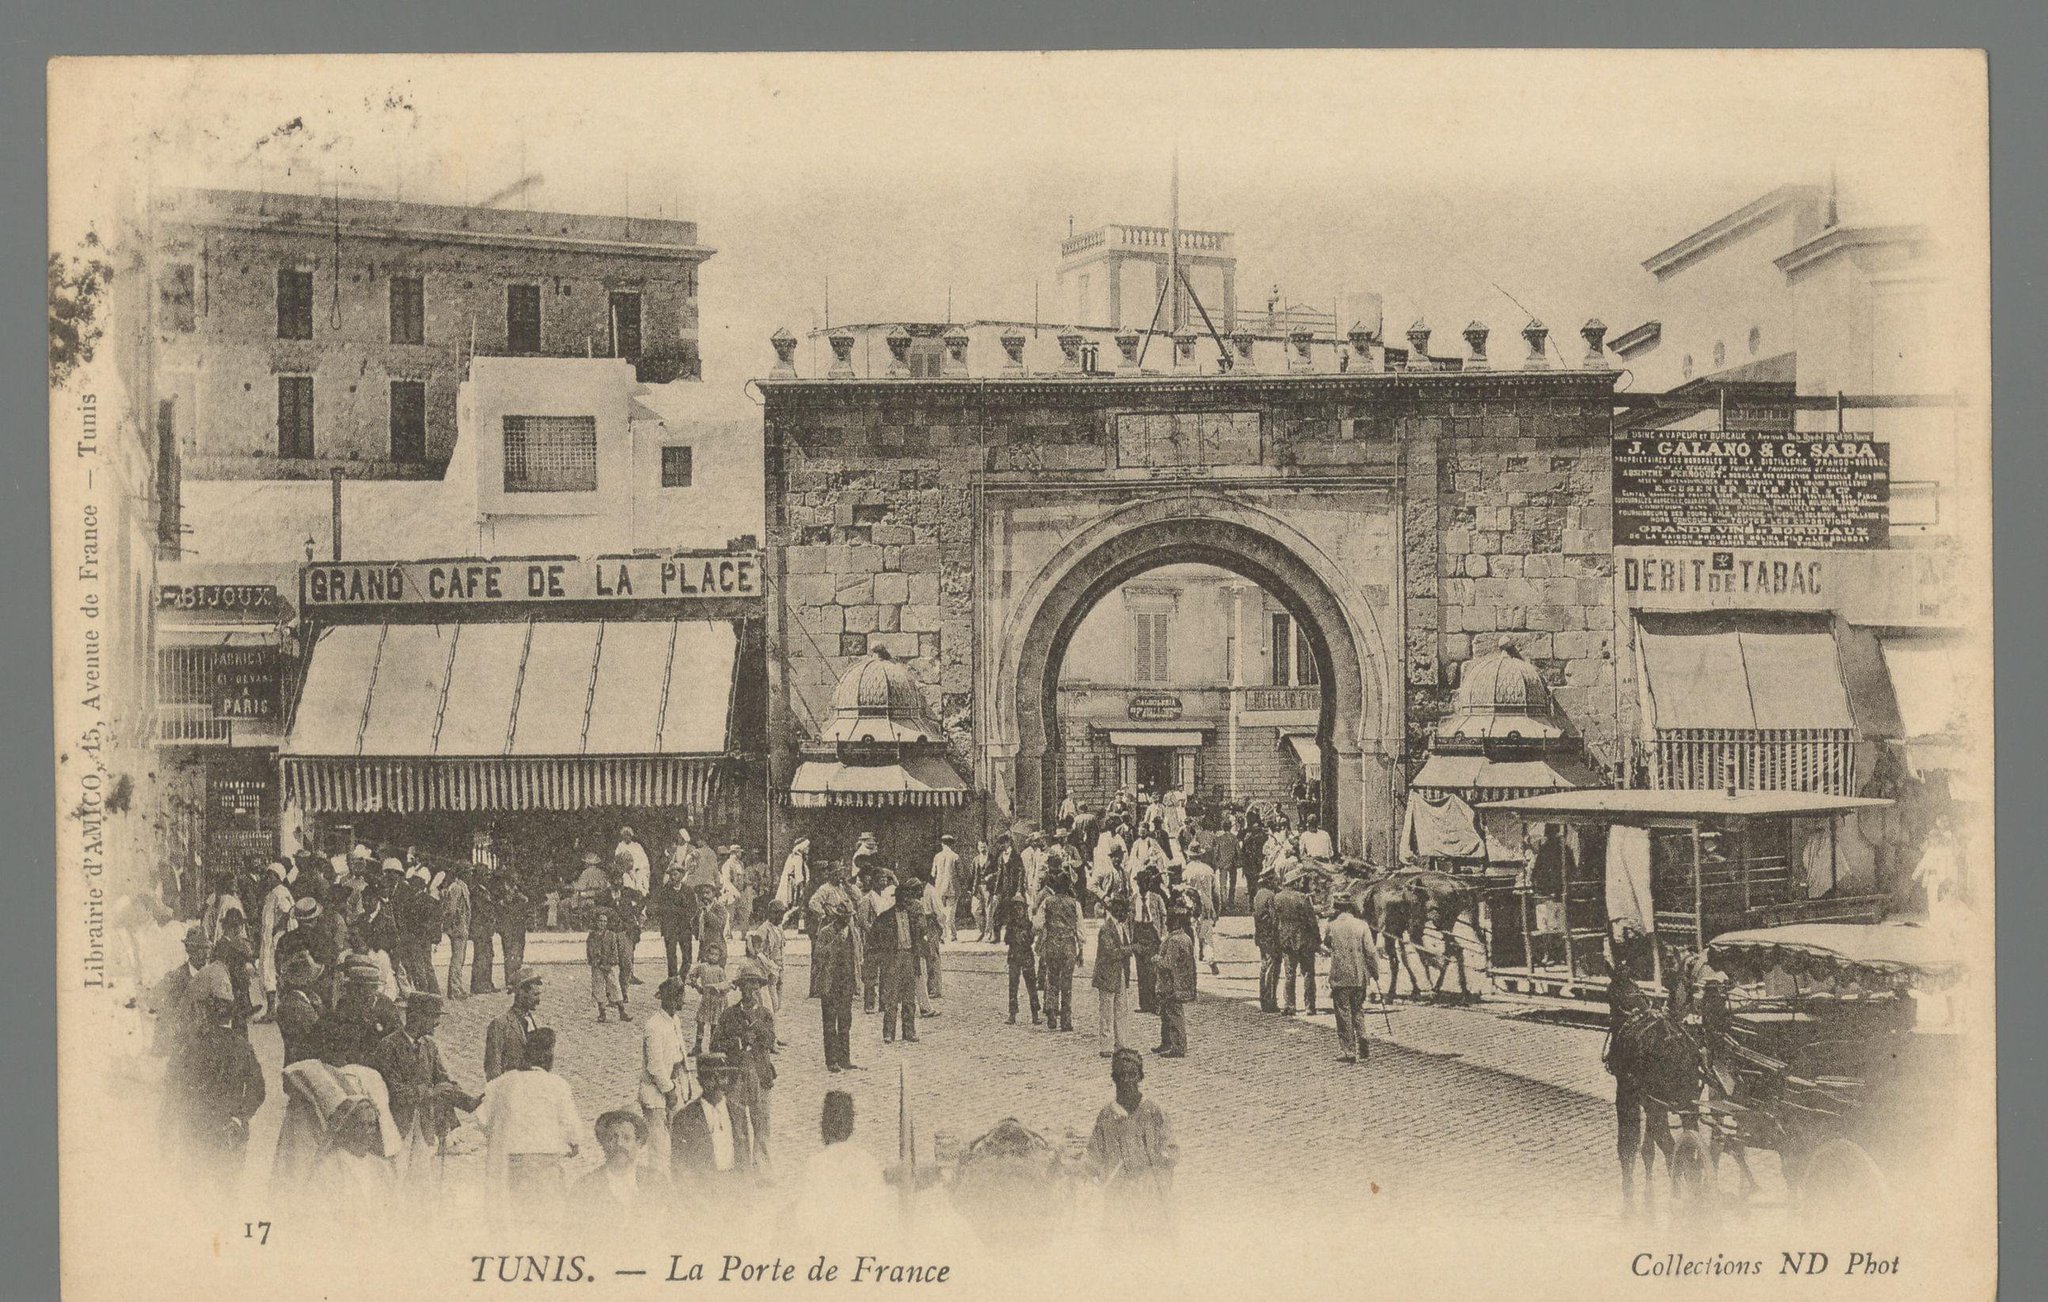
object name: photomechanical print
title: Tunis - La Porte de France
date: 1900-1903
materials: cardboard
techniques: photograph, writing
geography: paris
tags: shop, store, city-gate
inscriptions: poststempel, verso, gestempeld